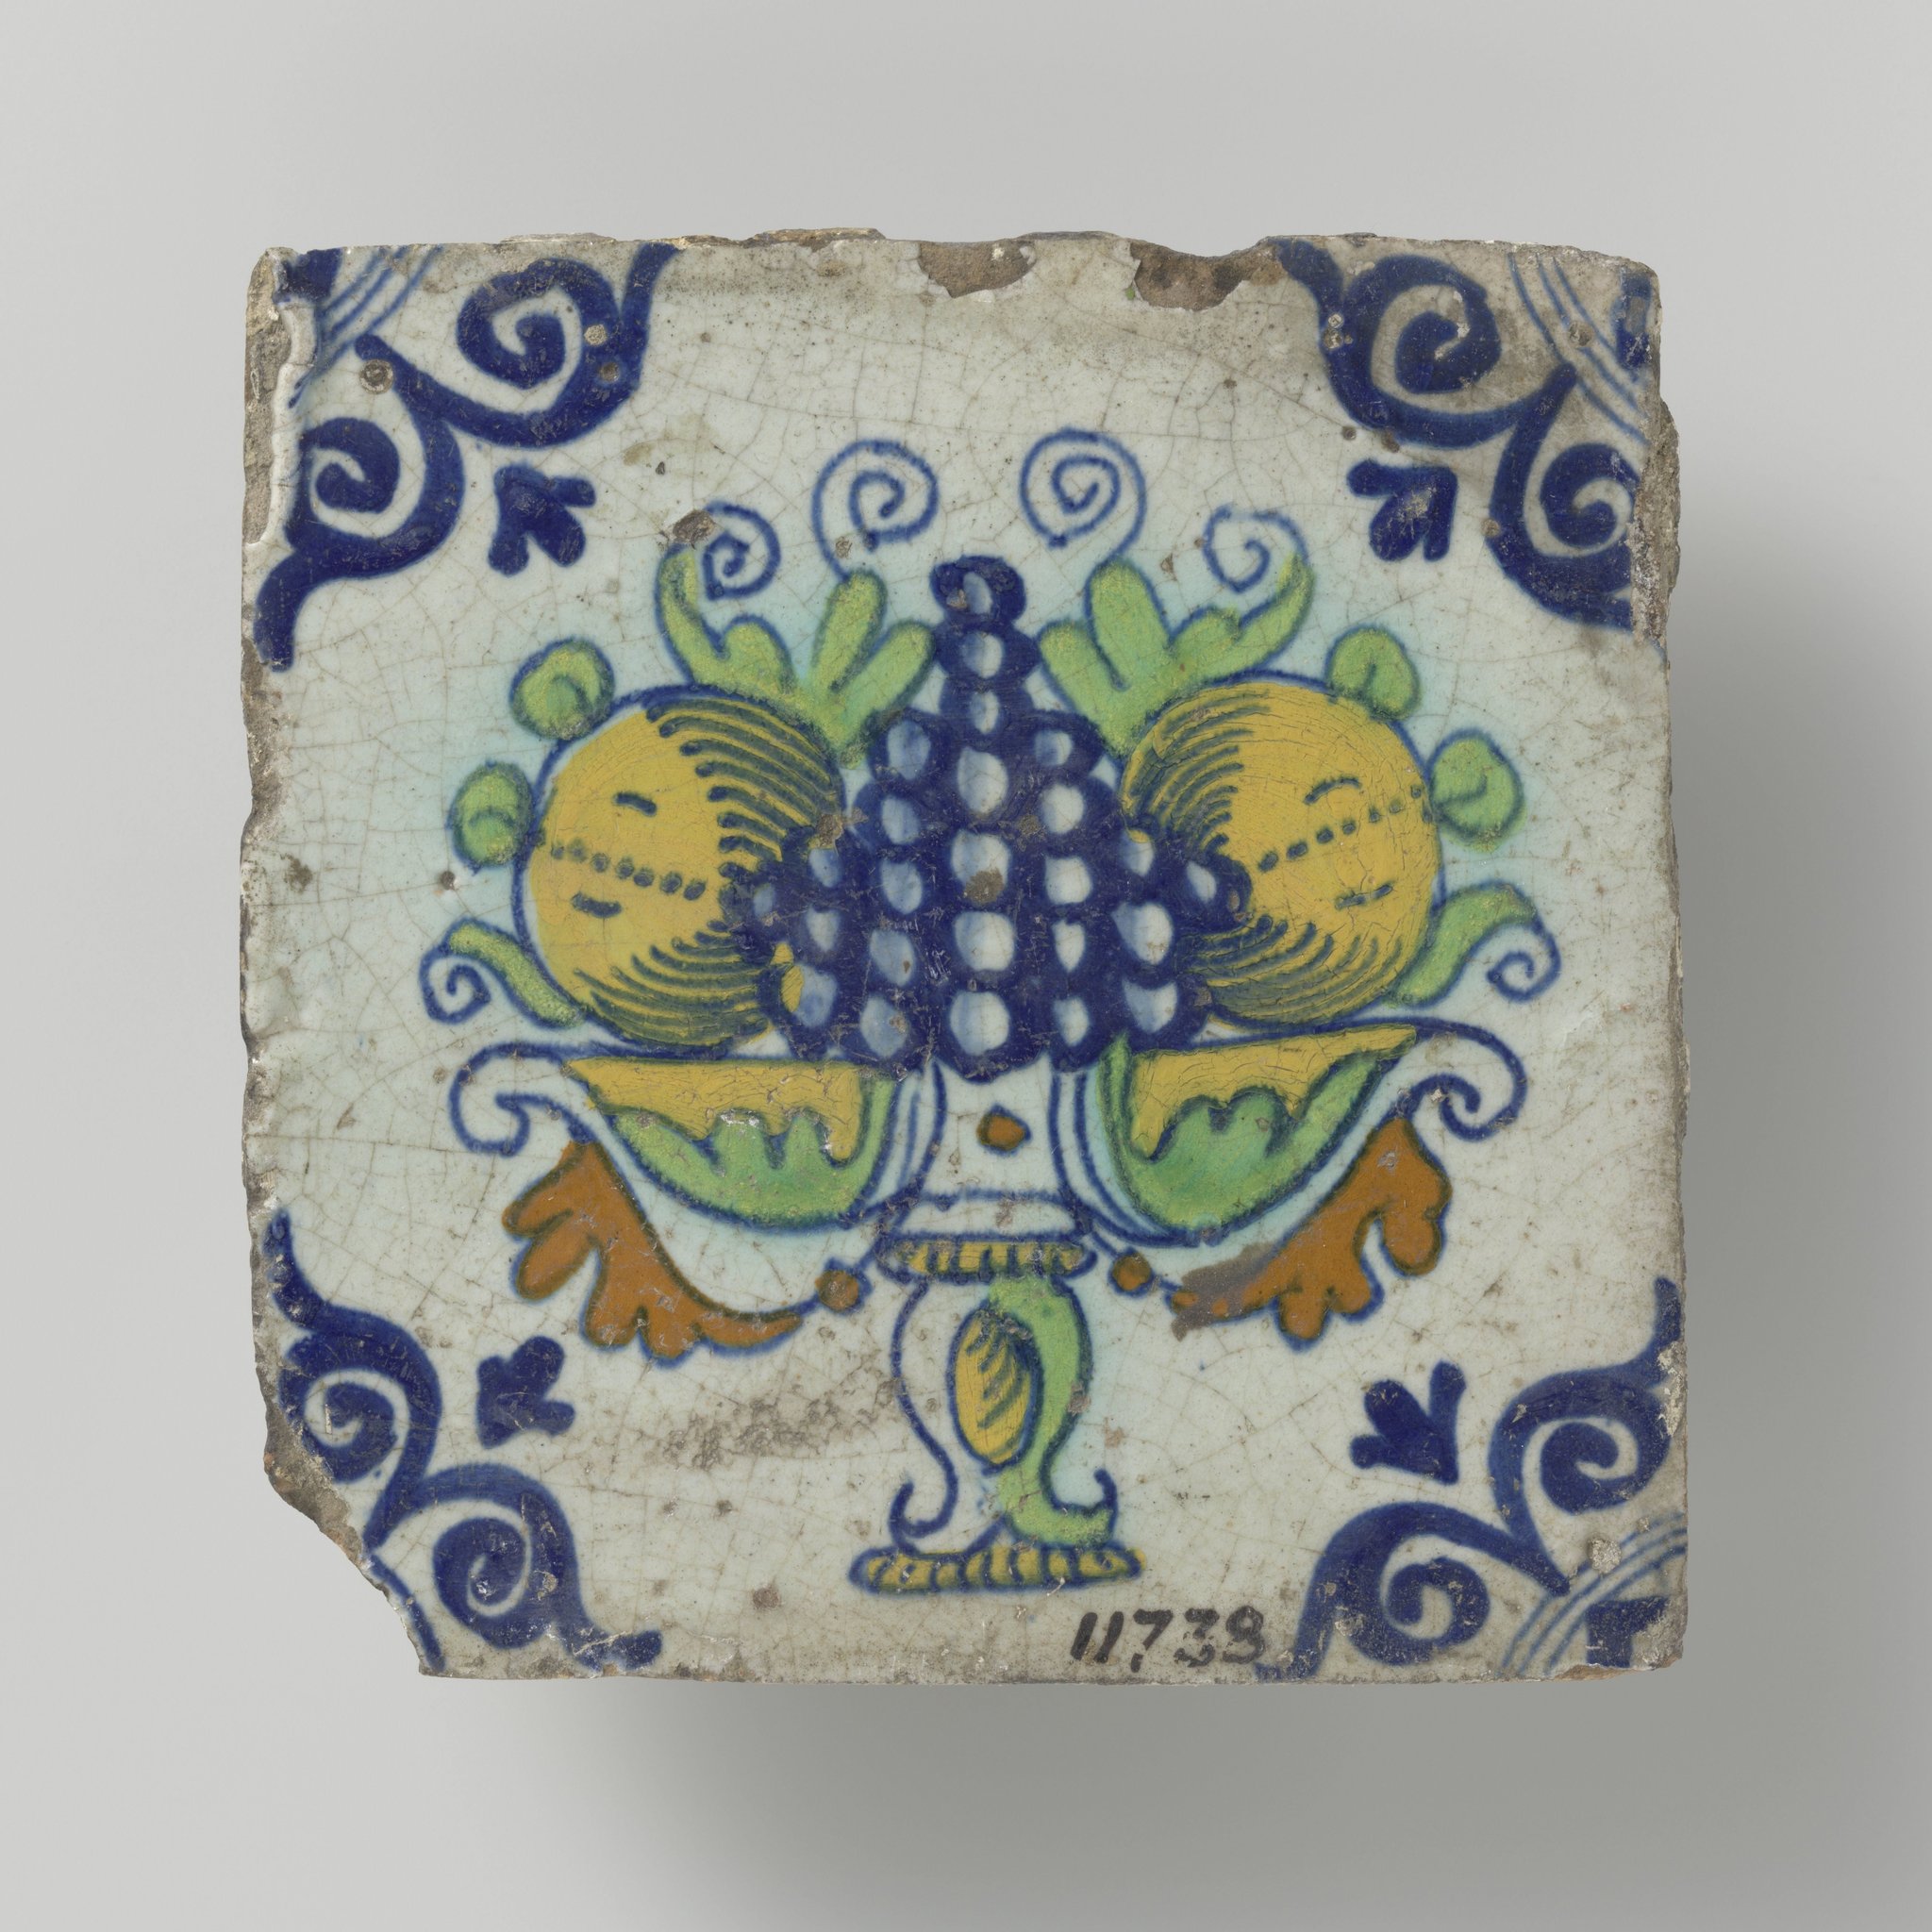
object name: tile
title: Tegel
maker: Anonymous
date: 1615-1635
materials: earthenware, glaze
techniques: maiolica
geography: netherlands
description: Tegel met een veelkleurig (blauw, groen, geel en oranje) geschilderde fruitschaal. In de hoeken, een ossekop.